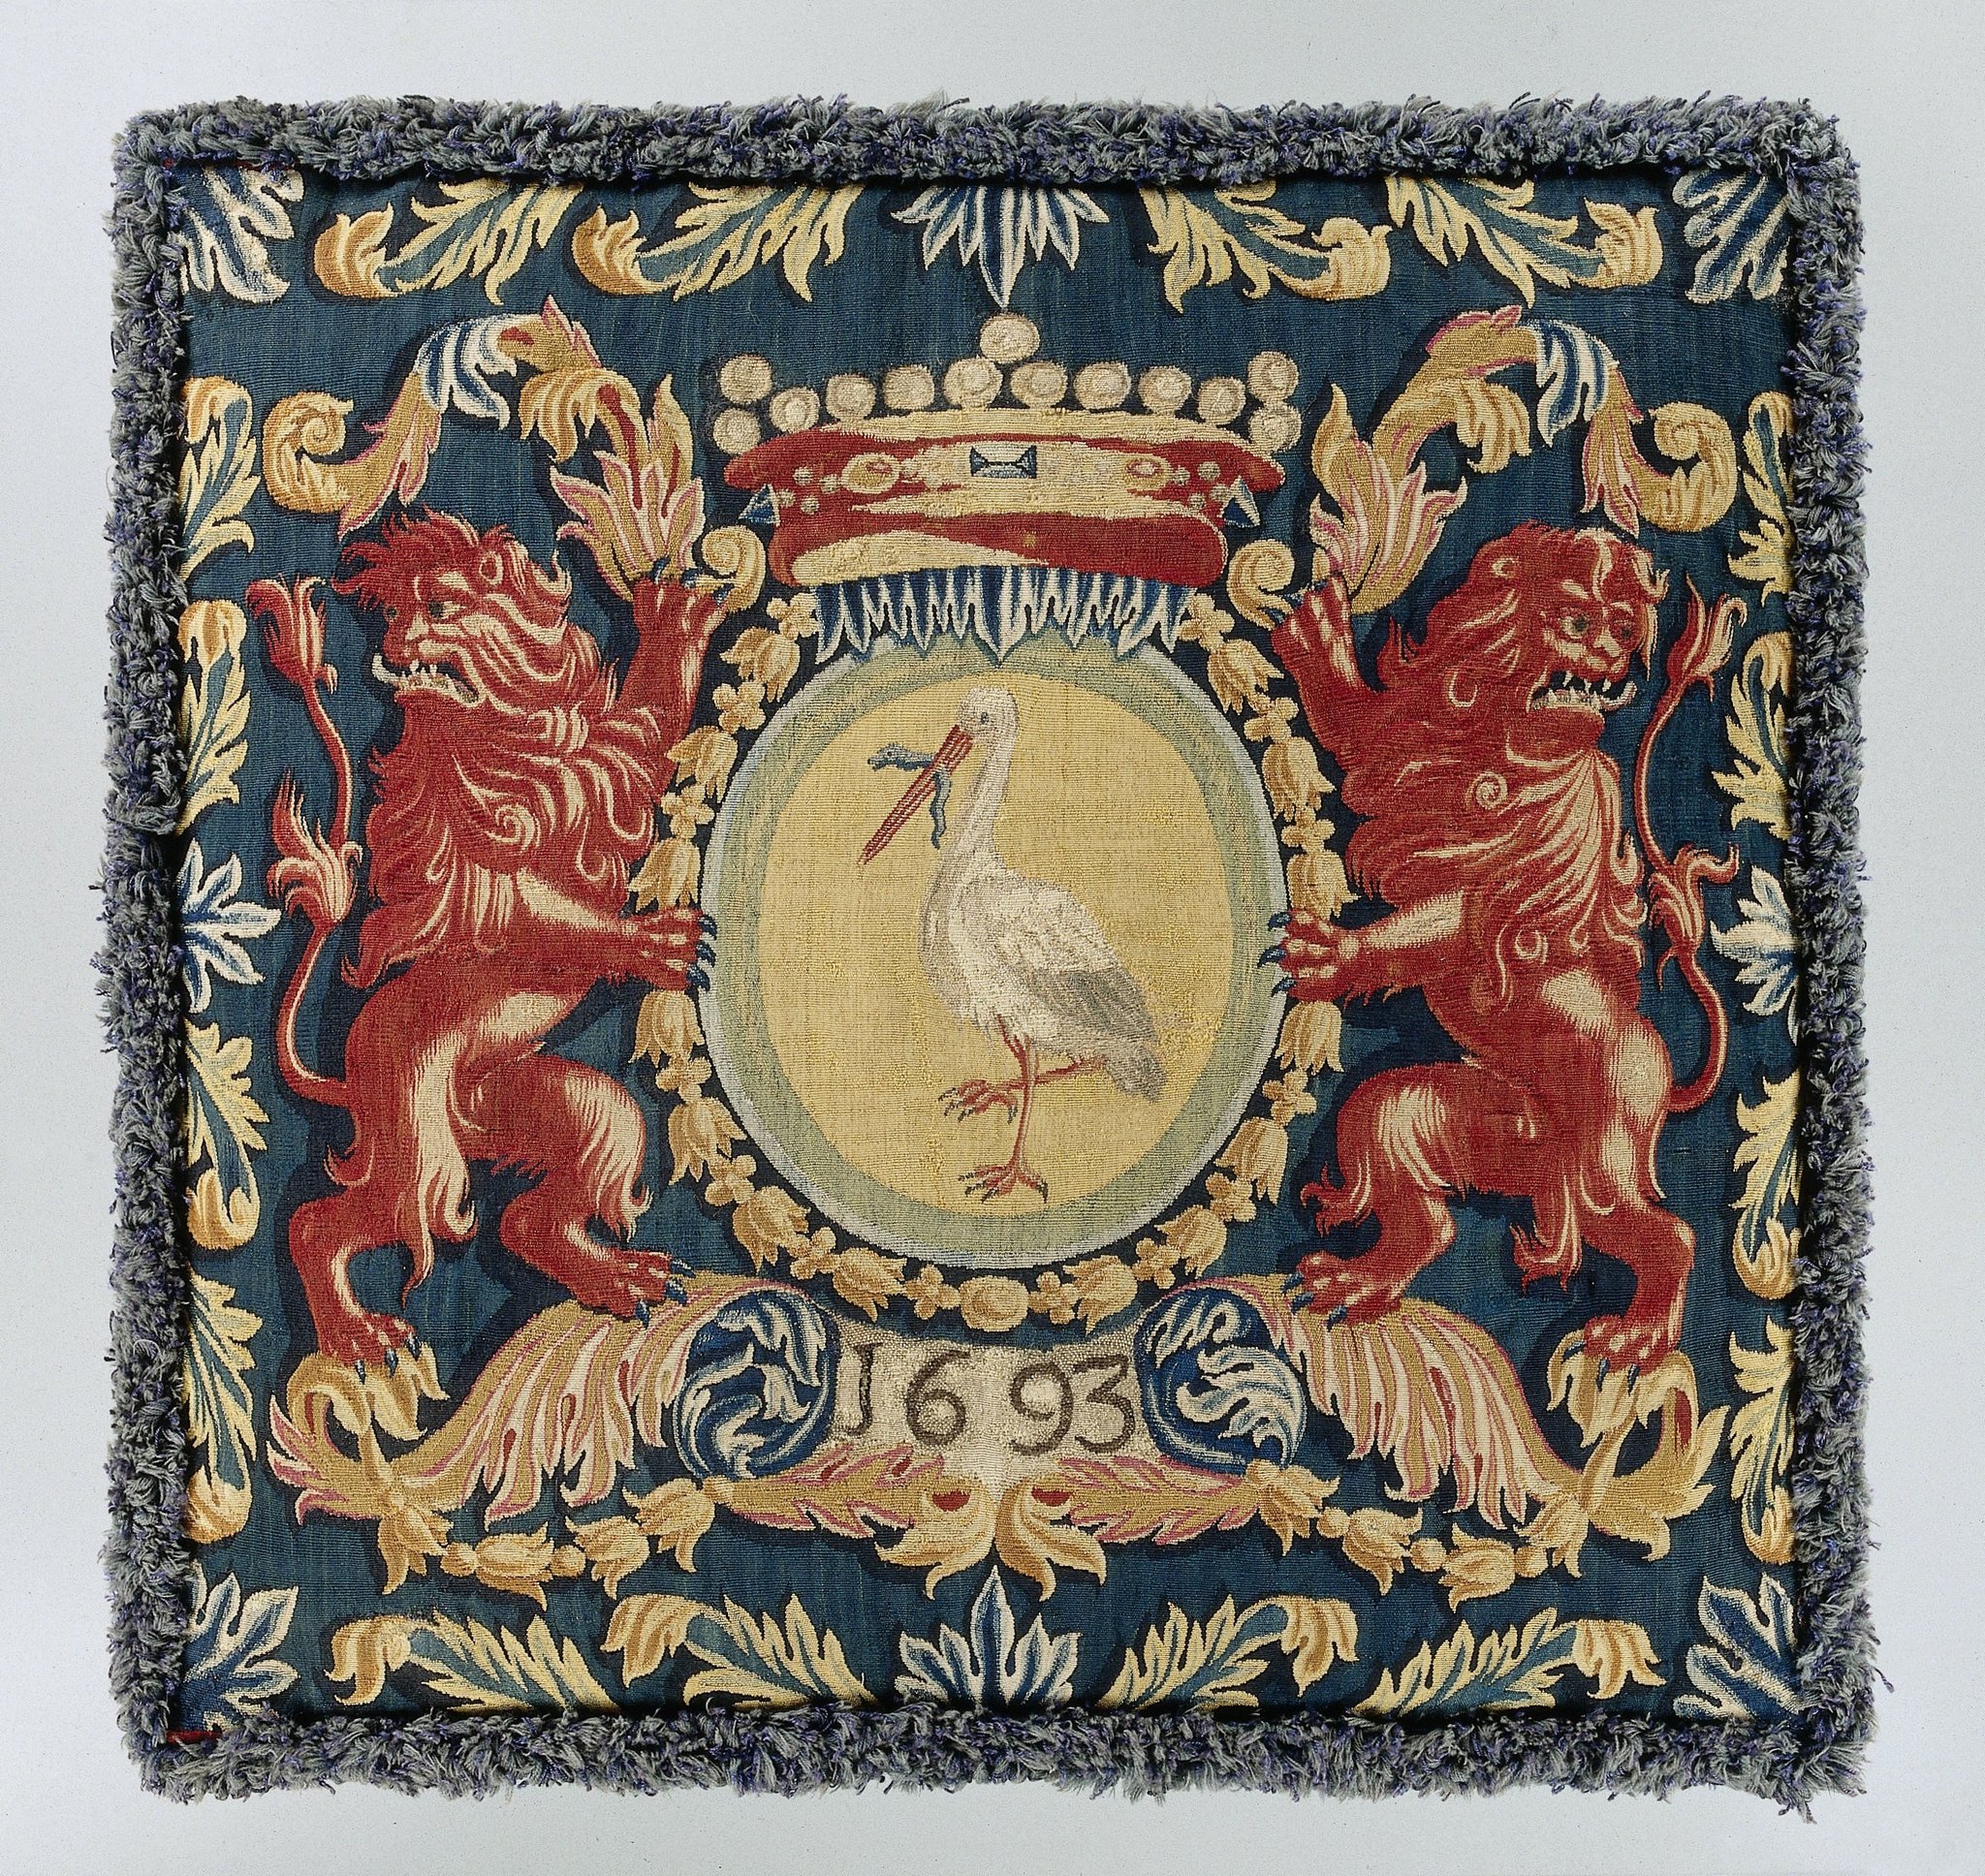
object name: pillow sham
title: Kussenovertrek met het gemeentewapen van Den Haag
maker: jacobus van der gucht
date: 1693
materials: silk, wool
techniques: tapestry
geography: delft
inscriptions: date: ‘1693’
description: Kussenblad van een magistratenkussen van tapisserieweefsel. Tegen een blauwe grond het gekroonde wapen van 's-Gravenhage. In een medaillon is op een geel fond de ooievaar met een slang in de snavel afgebeeld. Het wapen wordt gesteund door twee klimmende leeuwen in rood. Onder het wapen is het jaartal 1693 ingeweven. Het geheel is omgeven door bladranken en bladeren.